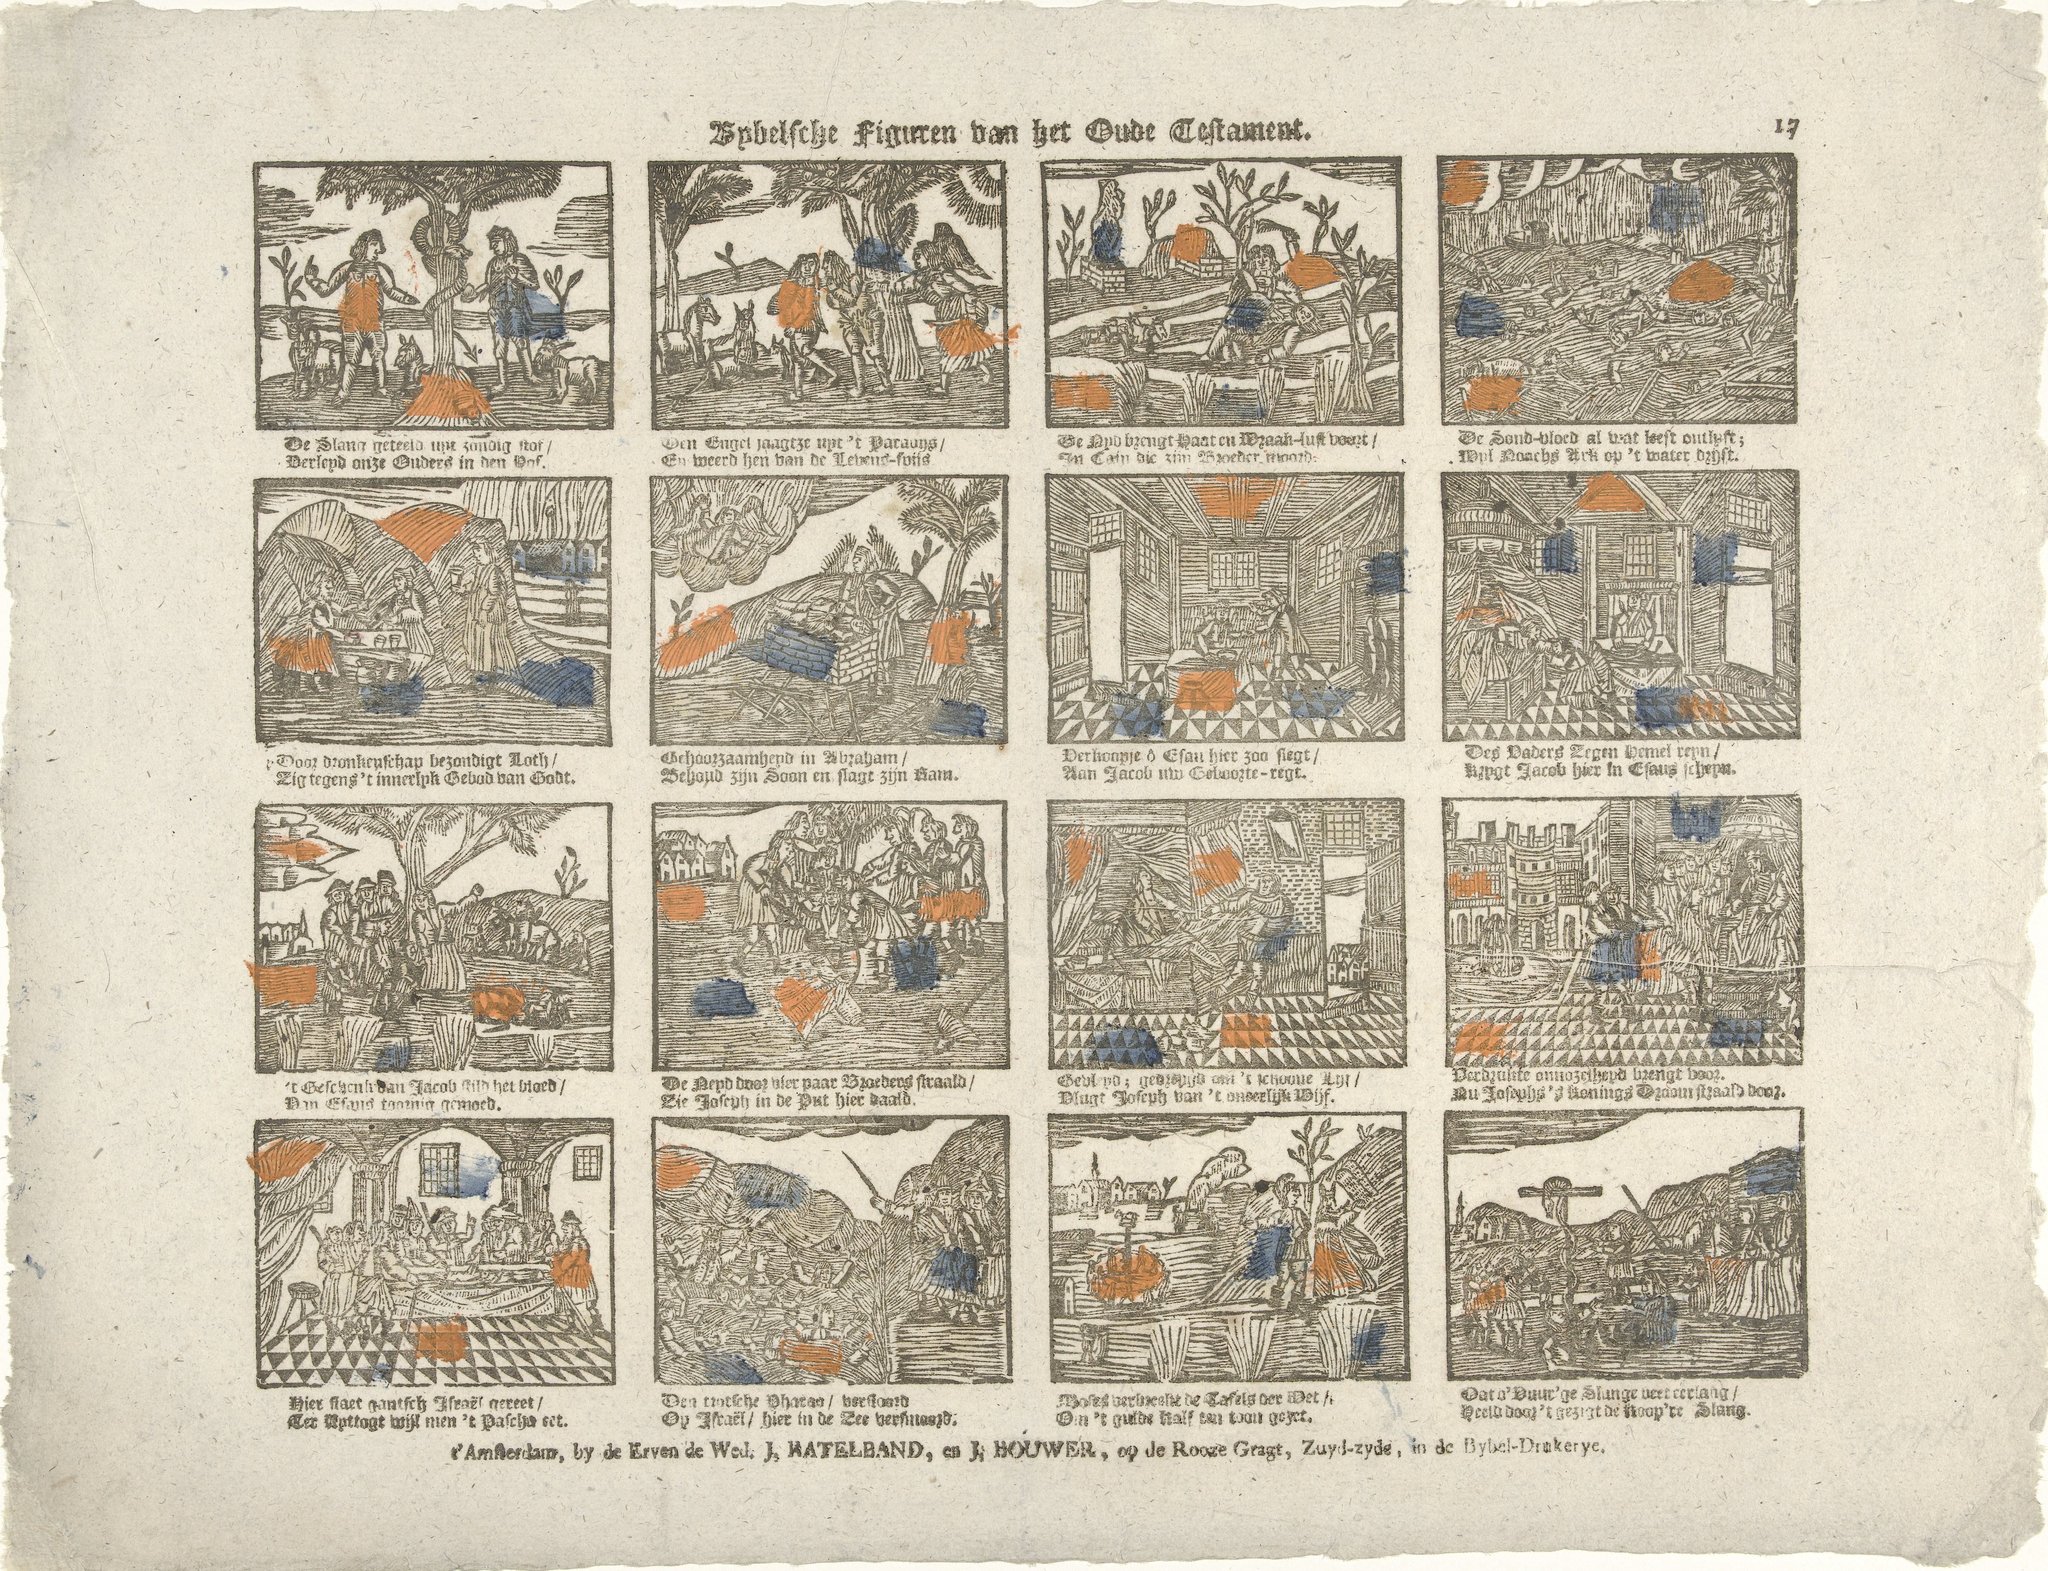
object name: print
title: Bybelsche figuren van het Oude Testament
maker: Anonymous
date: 1782-1793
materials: paper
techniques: colour, letterpress printing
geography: amsterdam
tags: old testament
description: Blad met 16 voorstellingen van verhalen uit het Oude Testament. Onder elke afbeelding een tweeregelig vers. Genummerd rechtsboven: 17.